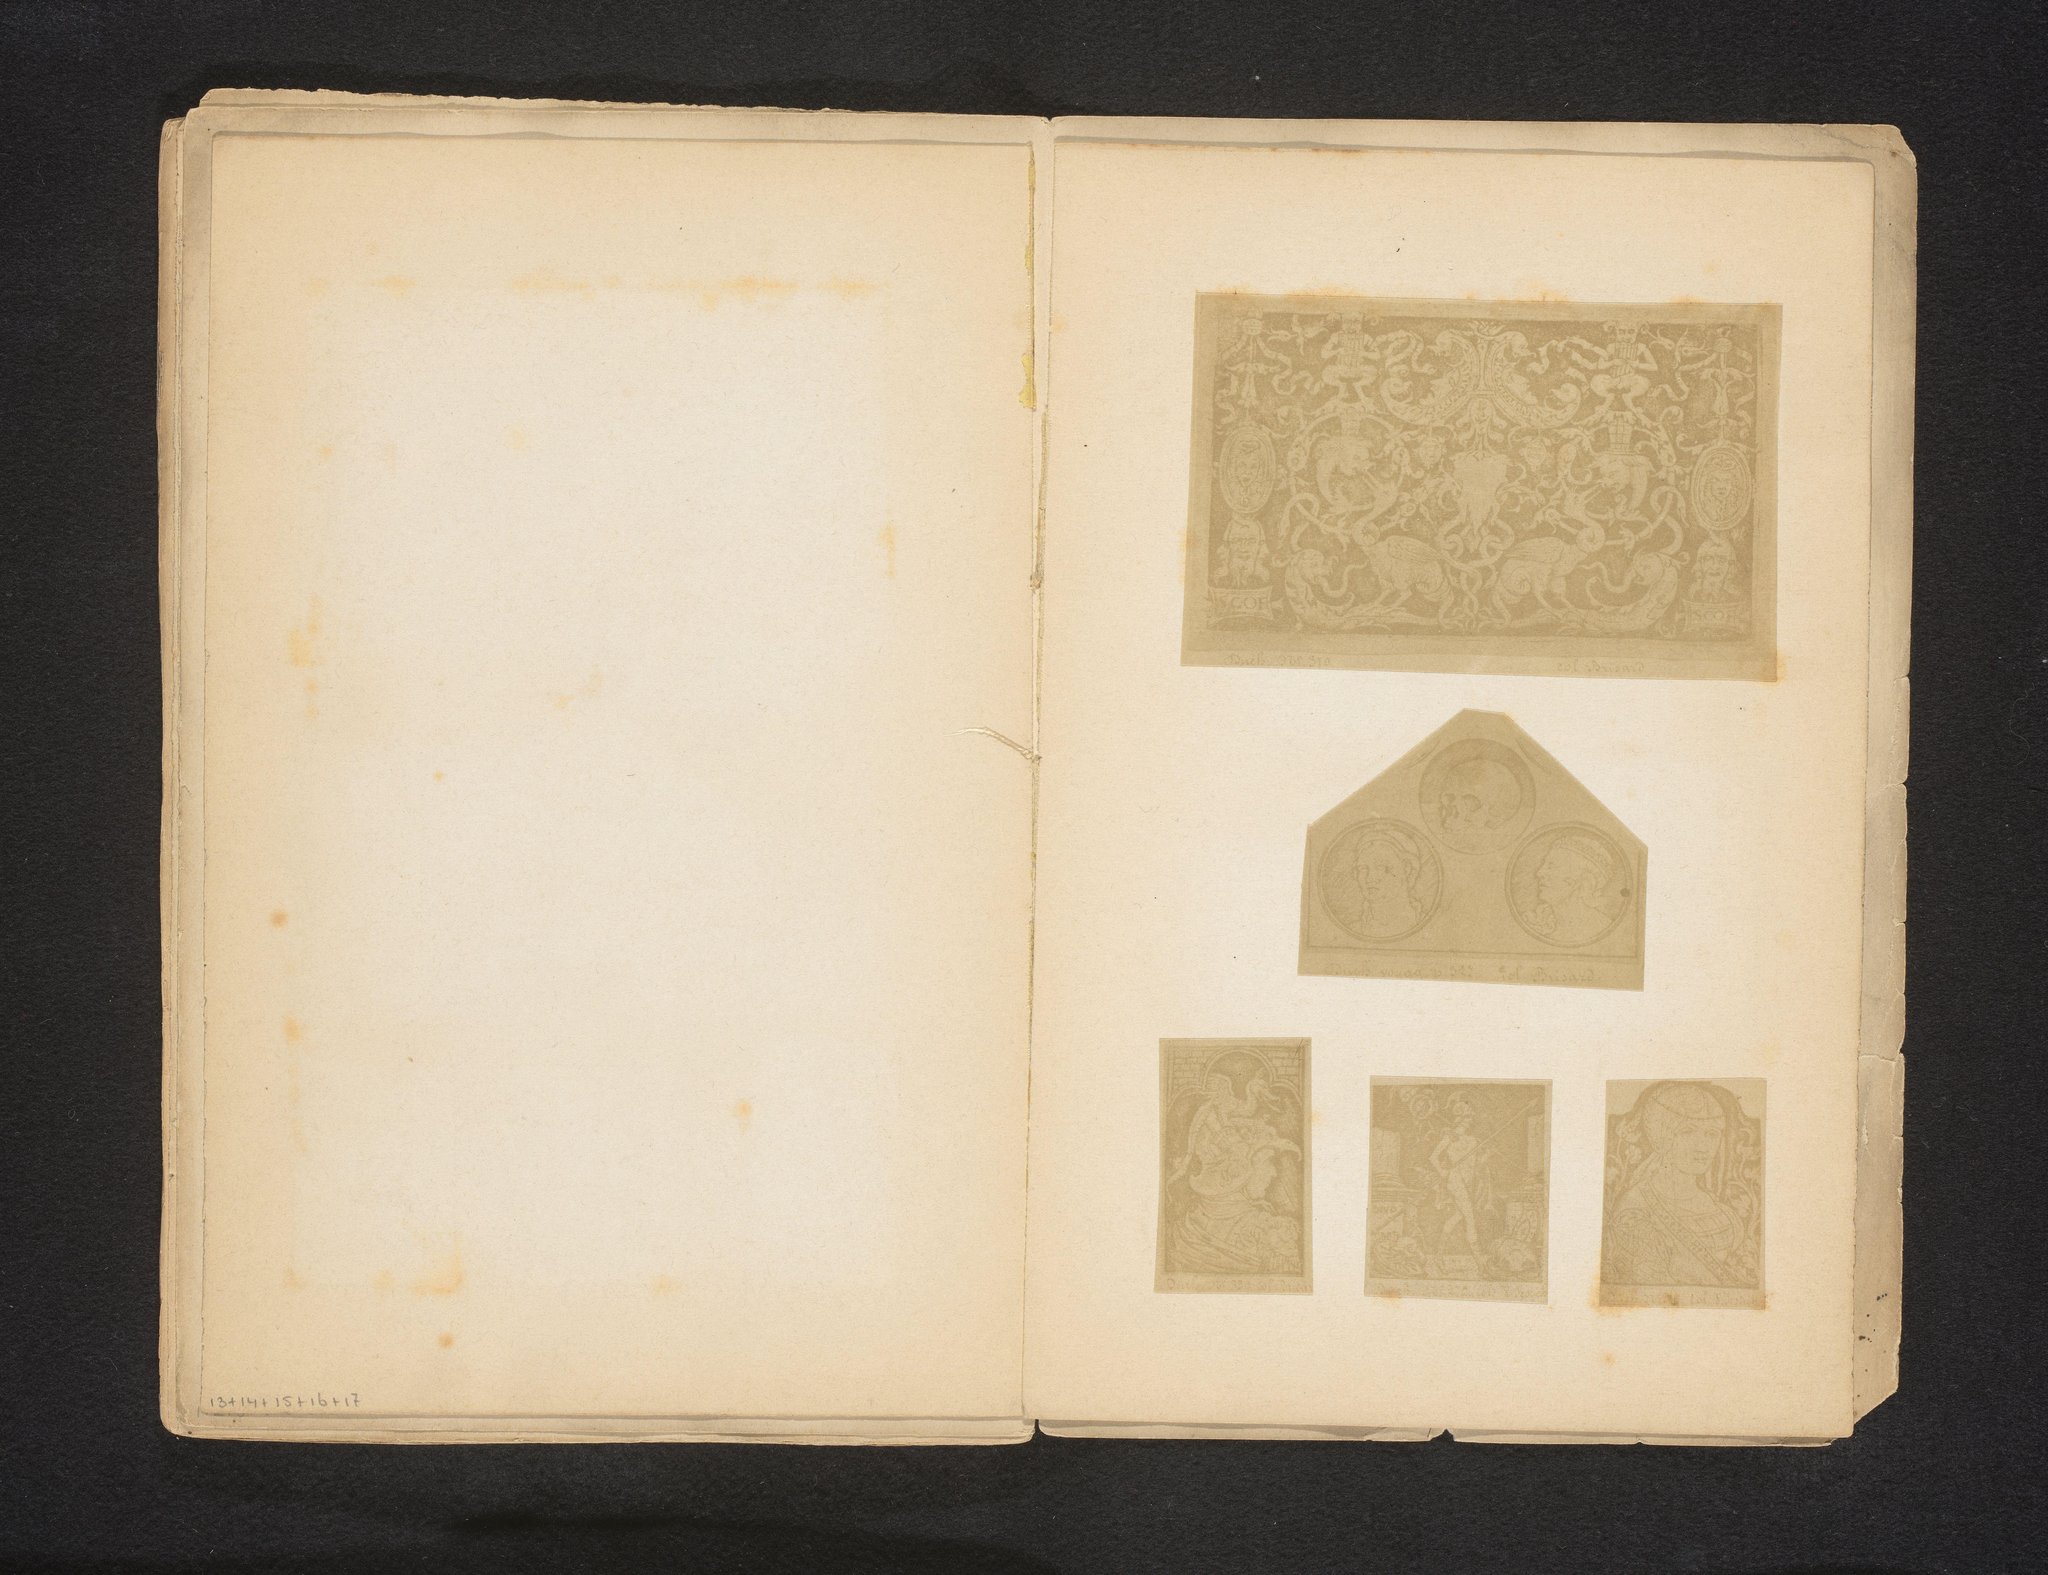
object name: page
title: Fotoreproductie van een prent van een krijger met een trofee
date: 1852-1857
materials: photographic support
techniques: salted paper print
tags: adult man, trophy ~ battle, war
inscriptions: inscription: ‘Duch. No 272. col. V. Sestich’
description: Foto op blad met vijf foto's op zevende ongenummerde pagina na pagina 60.